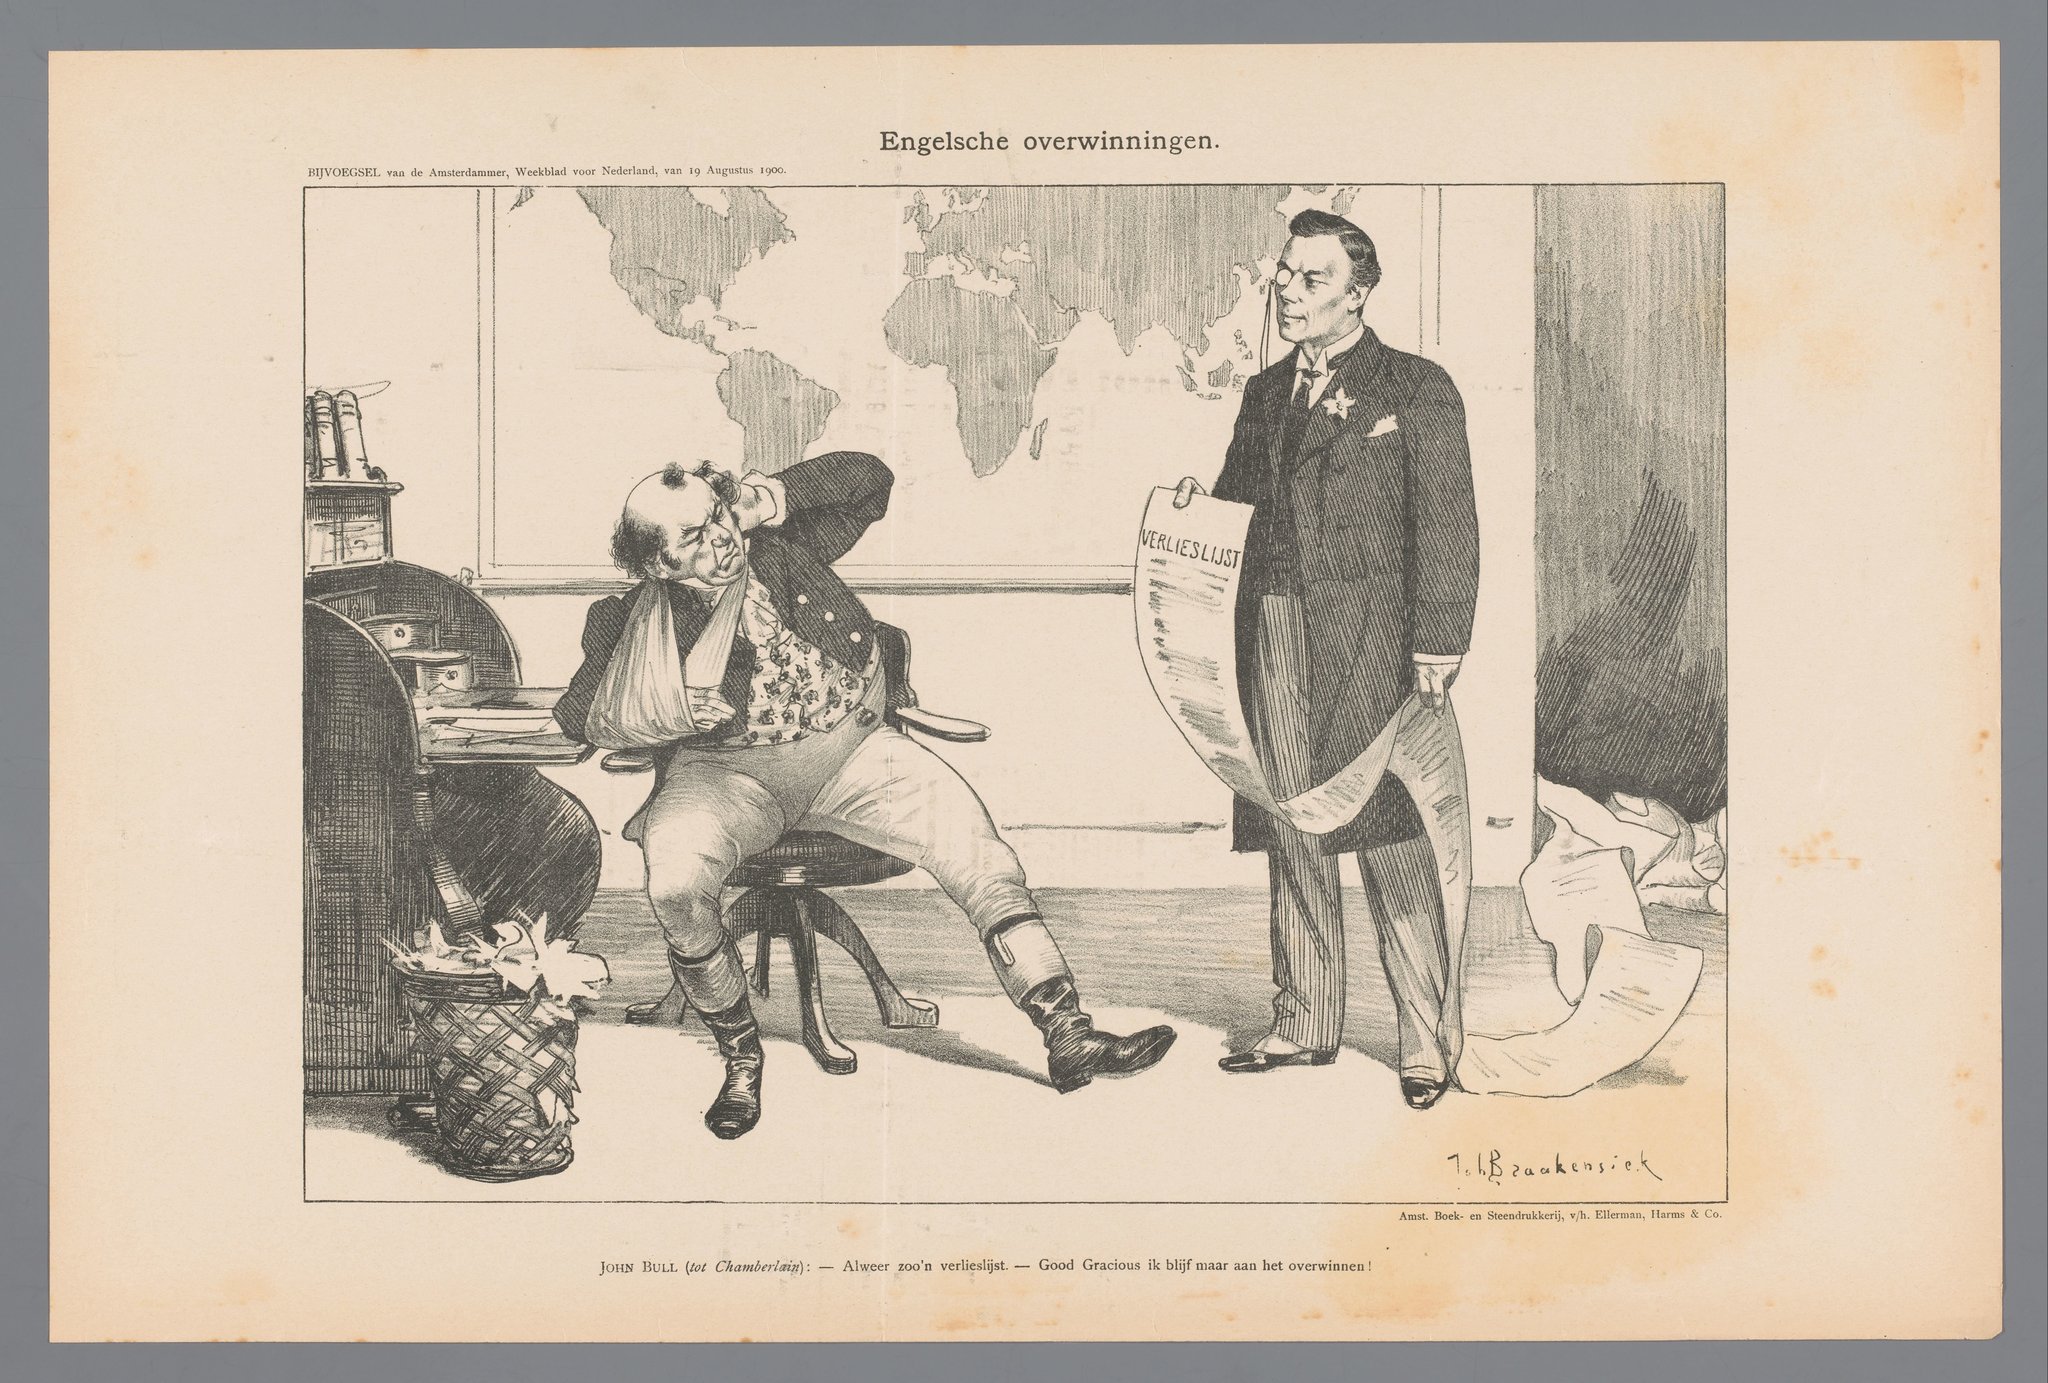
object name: cartoon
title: Engelsche overwinningen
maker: johan braakensiek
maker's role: draughtsman, print maker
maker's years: 1858-1940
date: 1900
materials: paper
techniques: lithograph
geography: amsterdam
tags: politician, personifications of countries, nations, states, districts, etc., historical persons, political caricatures and satires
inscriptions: date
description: Prent uit het bijvoegsel van: De Amsterdammer. Weekblad voor Nederland, 19 augustus 1900.